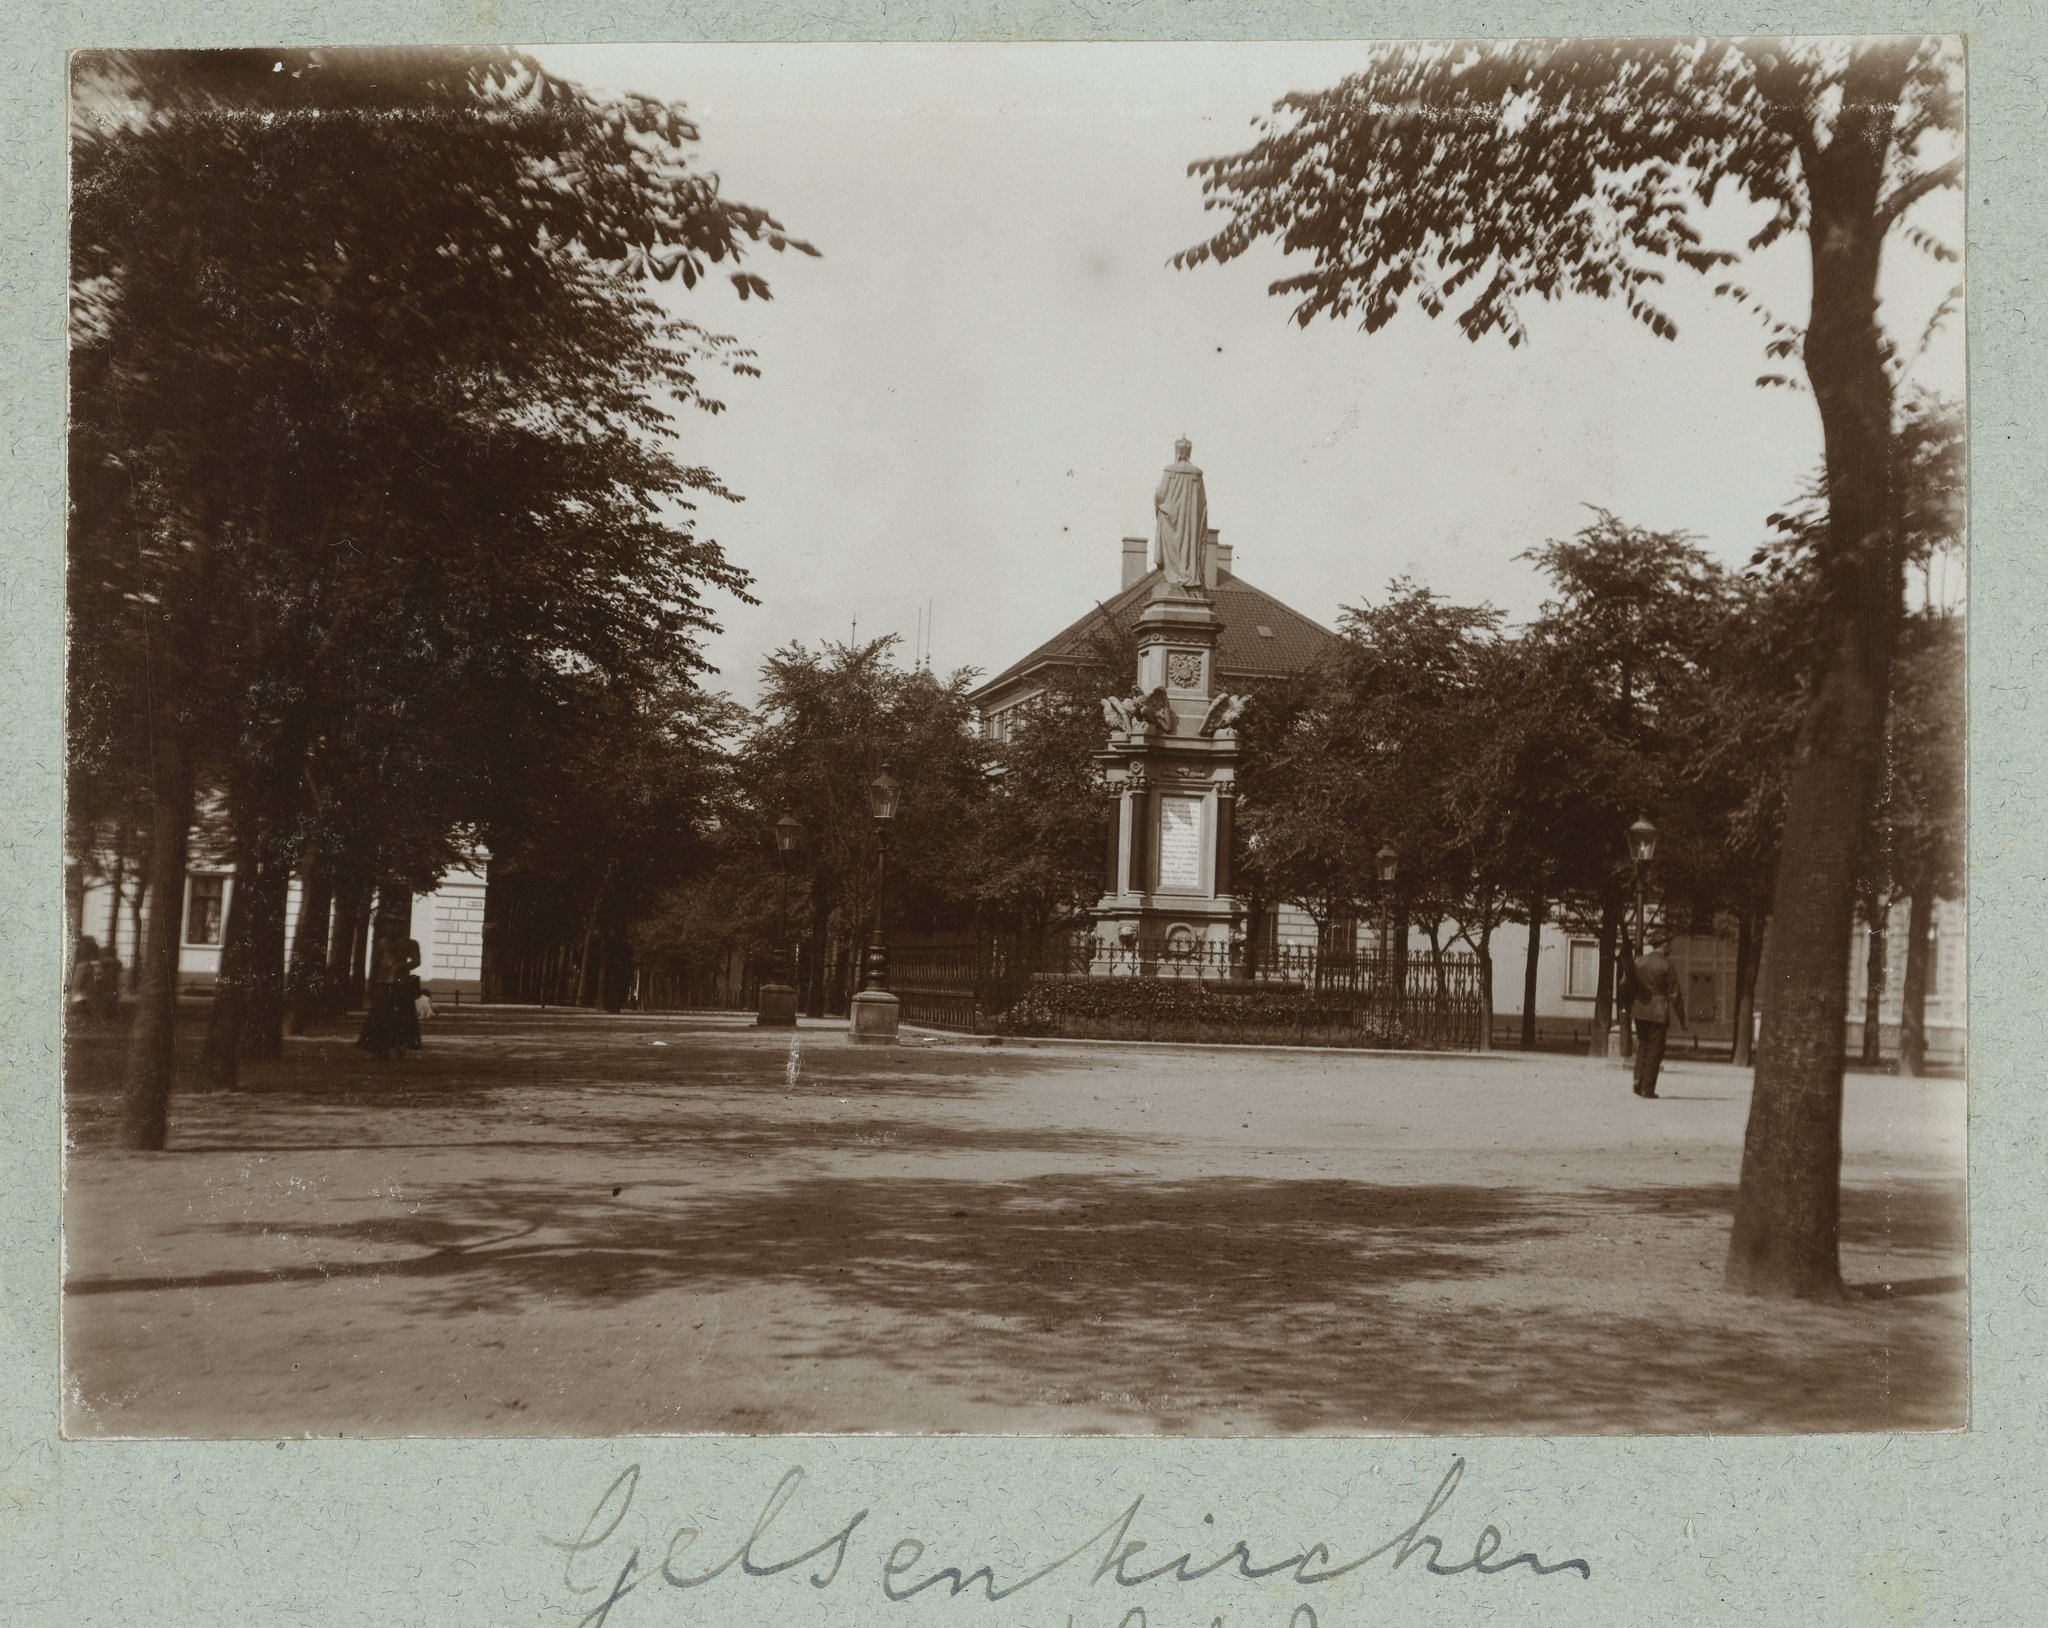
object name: photograph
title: De rostachtige kust nabij Torquay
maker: frits freerks fontein fz.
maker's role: fotograaf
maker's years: 1882-1928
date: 1902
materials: cardboard, paper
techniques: gelatin silver print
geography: netherlands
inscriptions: caption: ‘Gelsenkirchen 1902’